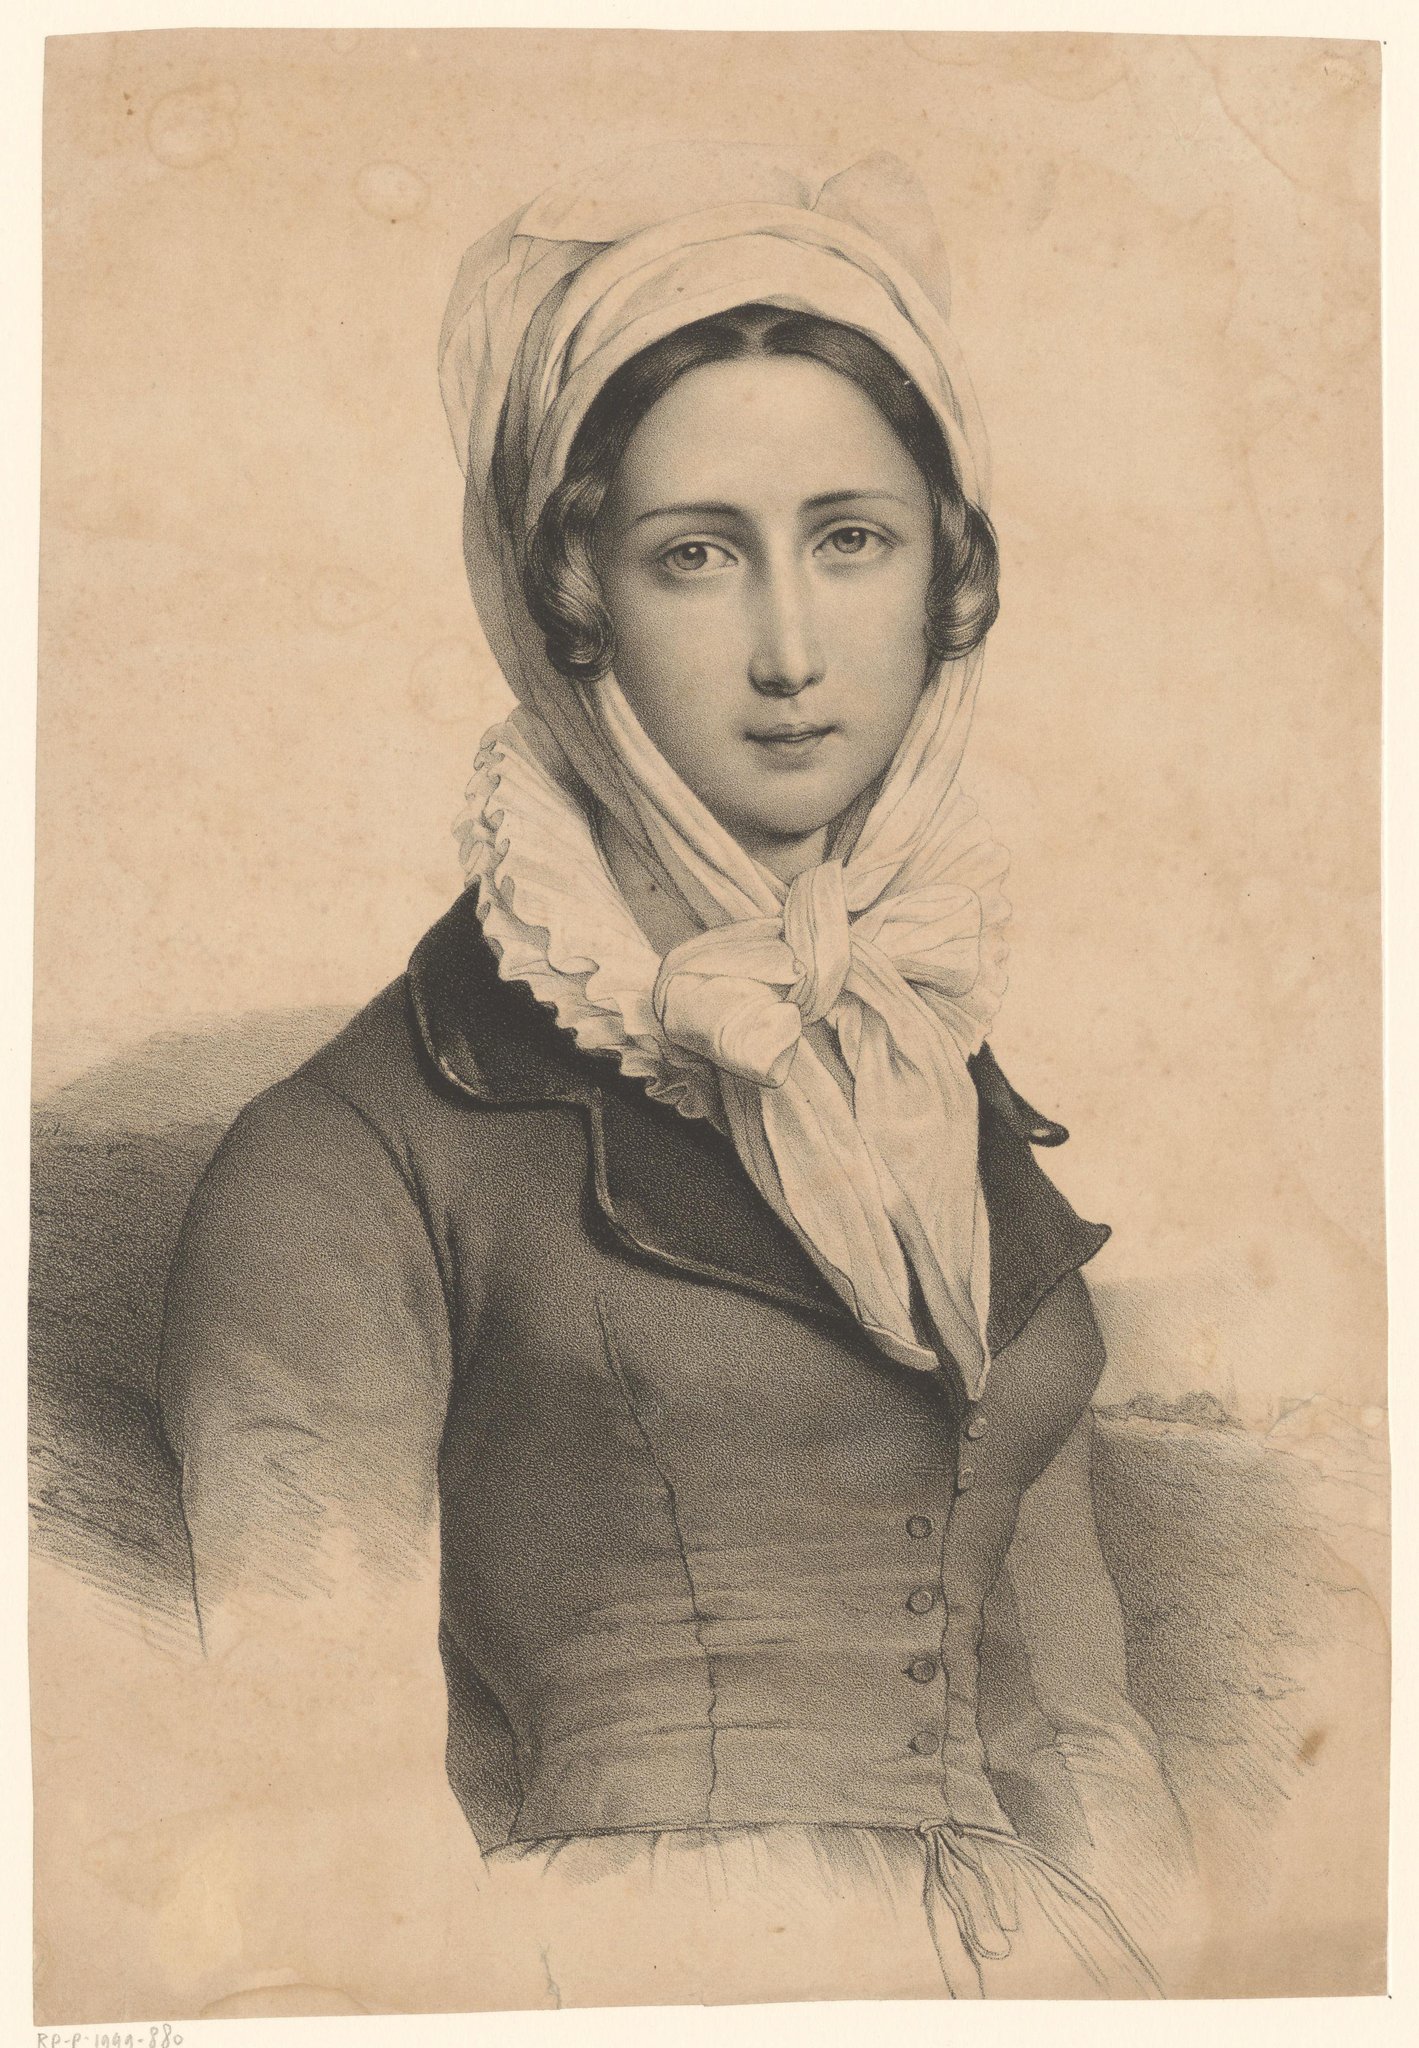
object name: print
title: Portret van een onbekende vrouw met hoofddoek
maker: Anonymous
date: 1820-1899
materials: paper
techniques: lithograph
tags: adult woman, head-gear, historical persons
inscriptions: collector's mark: Lugt 2228, collector's mark: Lugt 2760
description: Ten halve lijve, naar rechts, witte hoofddoek op het hoofd.